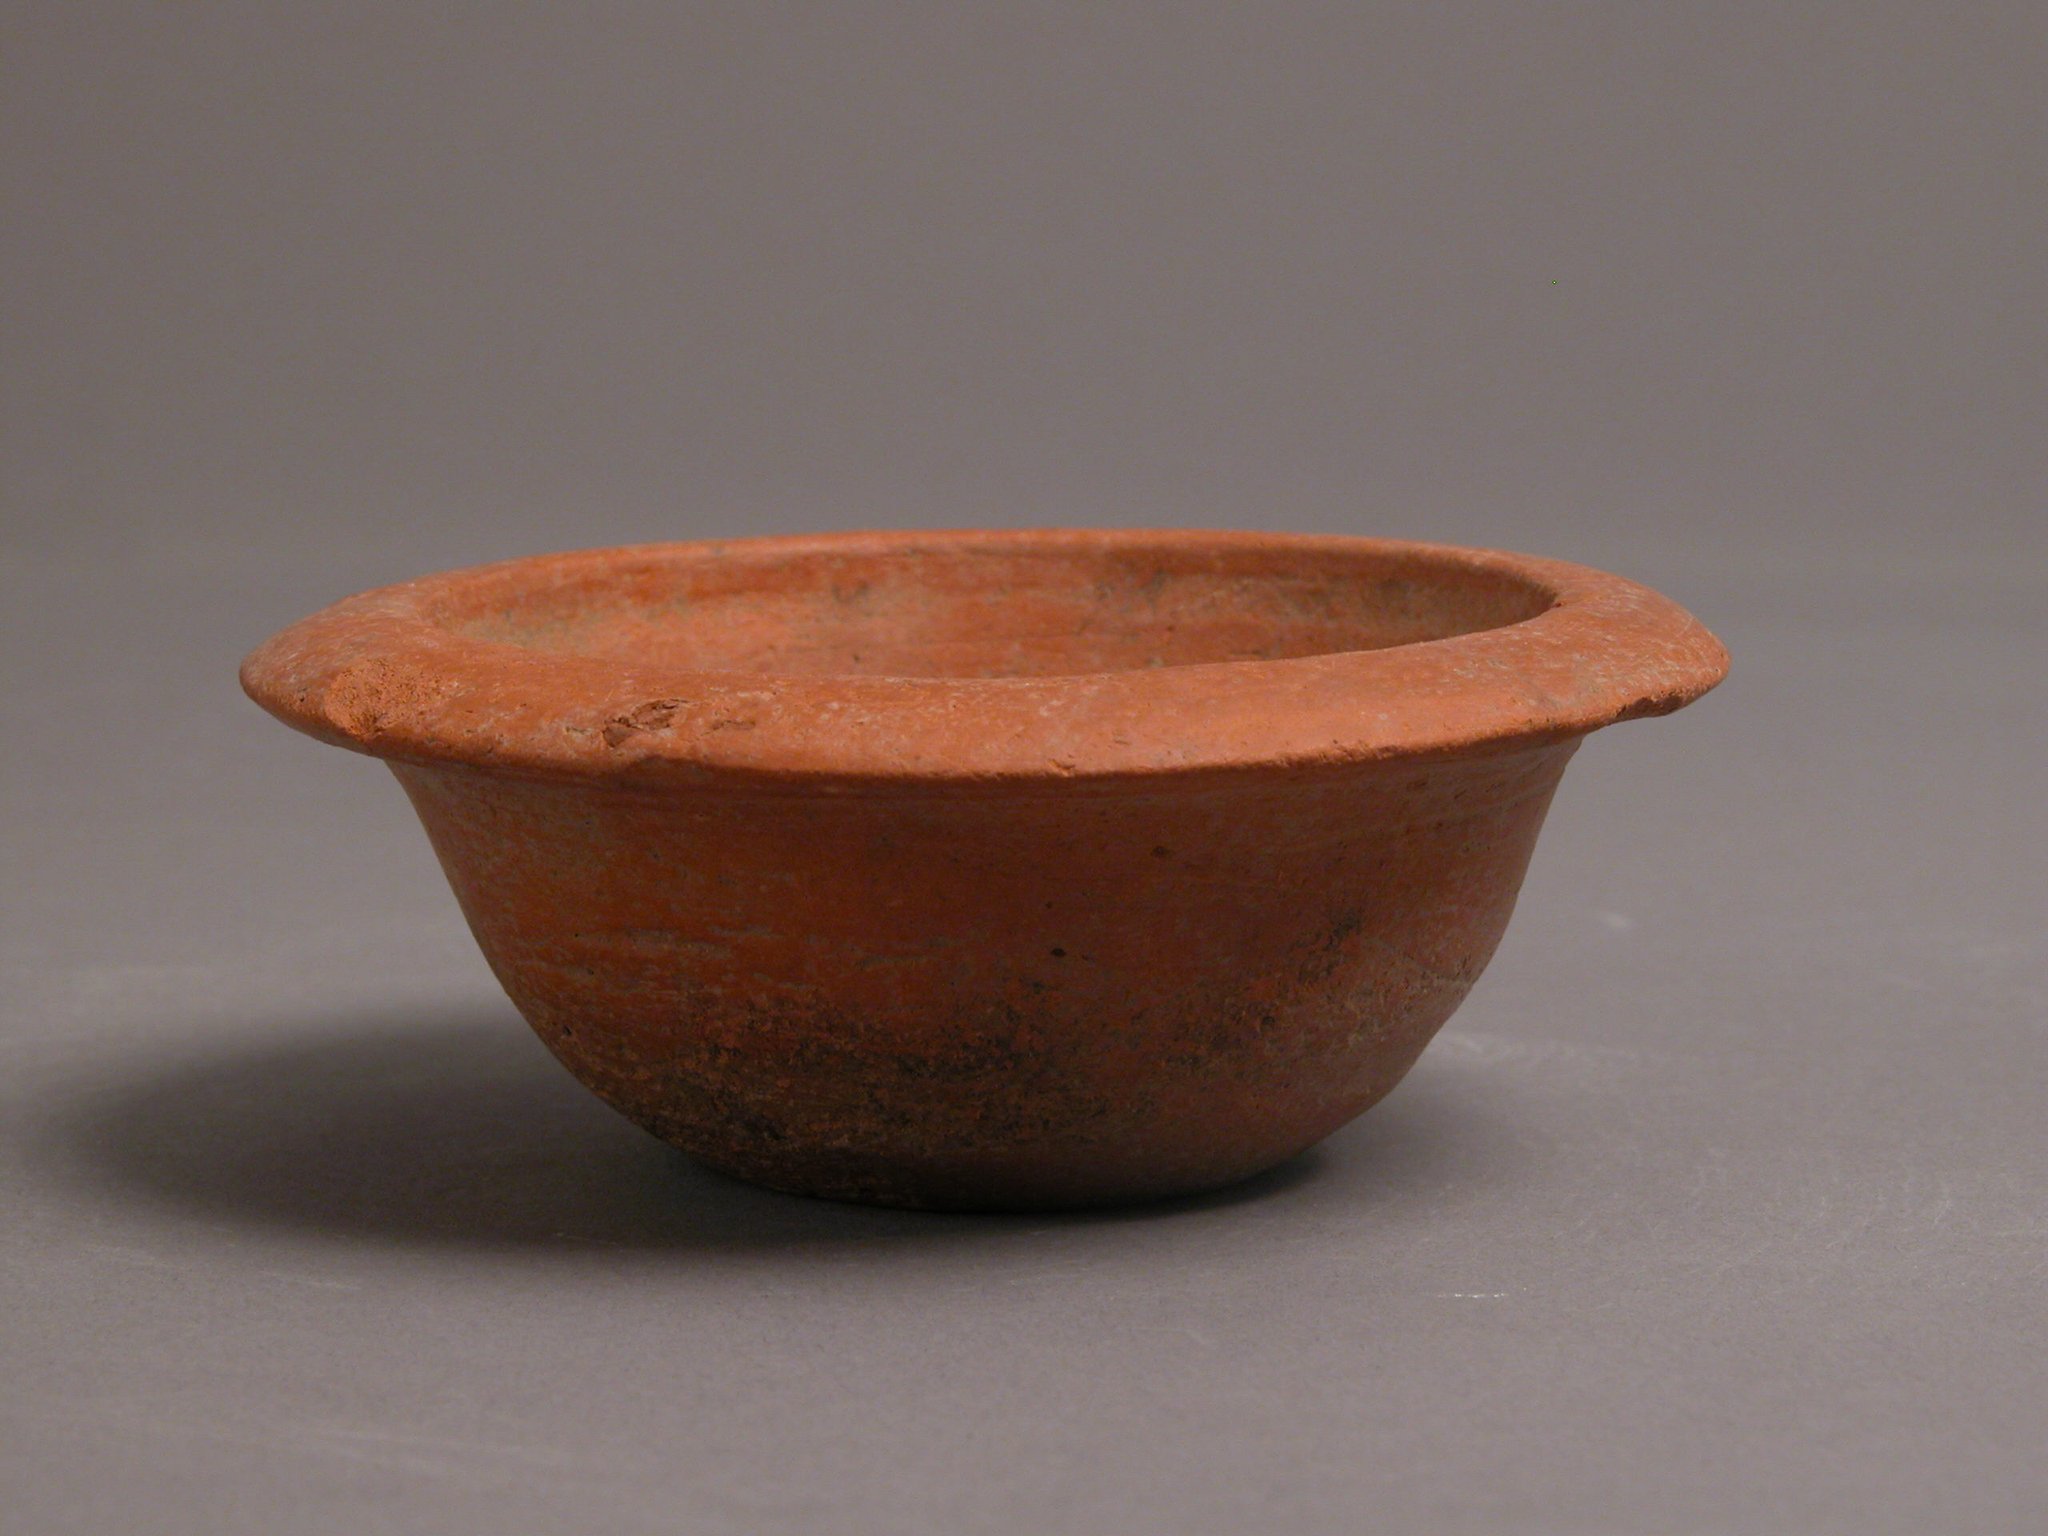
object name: bowl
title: Nesting Bowl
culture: coptic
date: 301-700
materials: earthenware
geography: egypt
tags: bowls